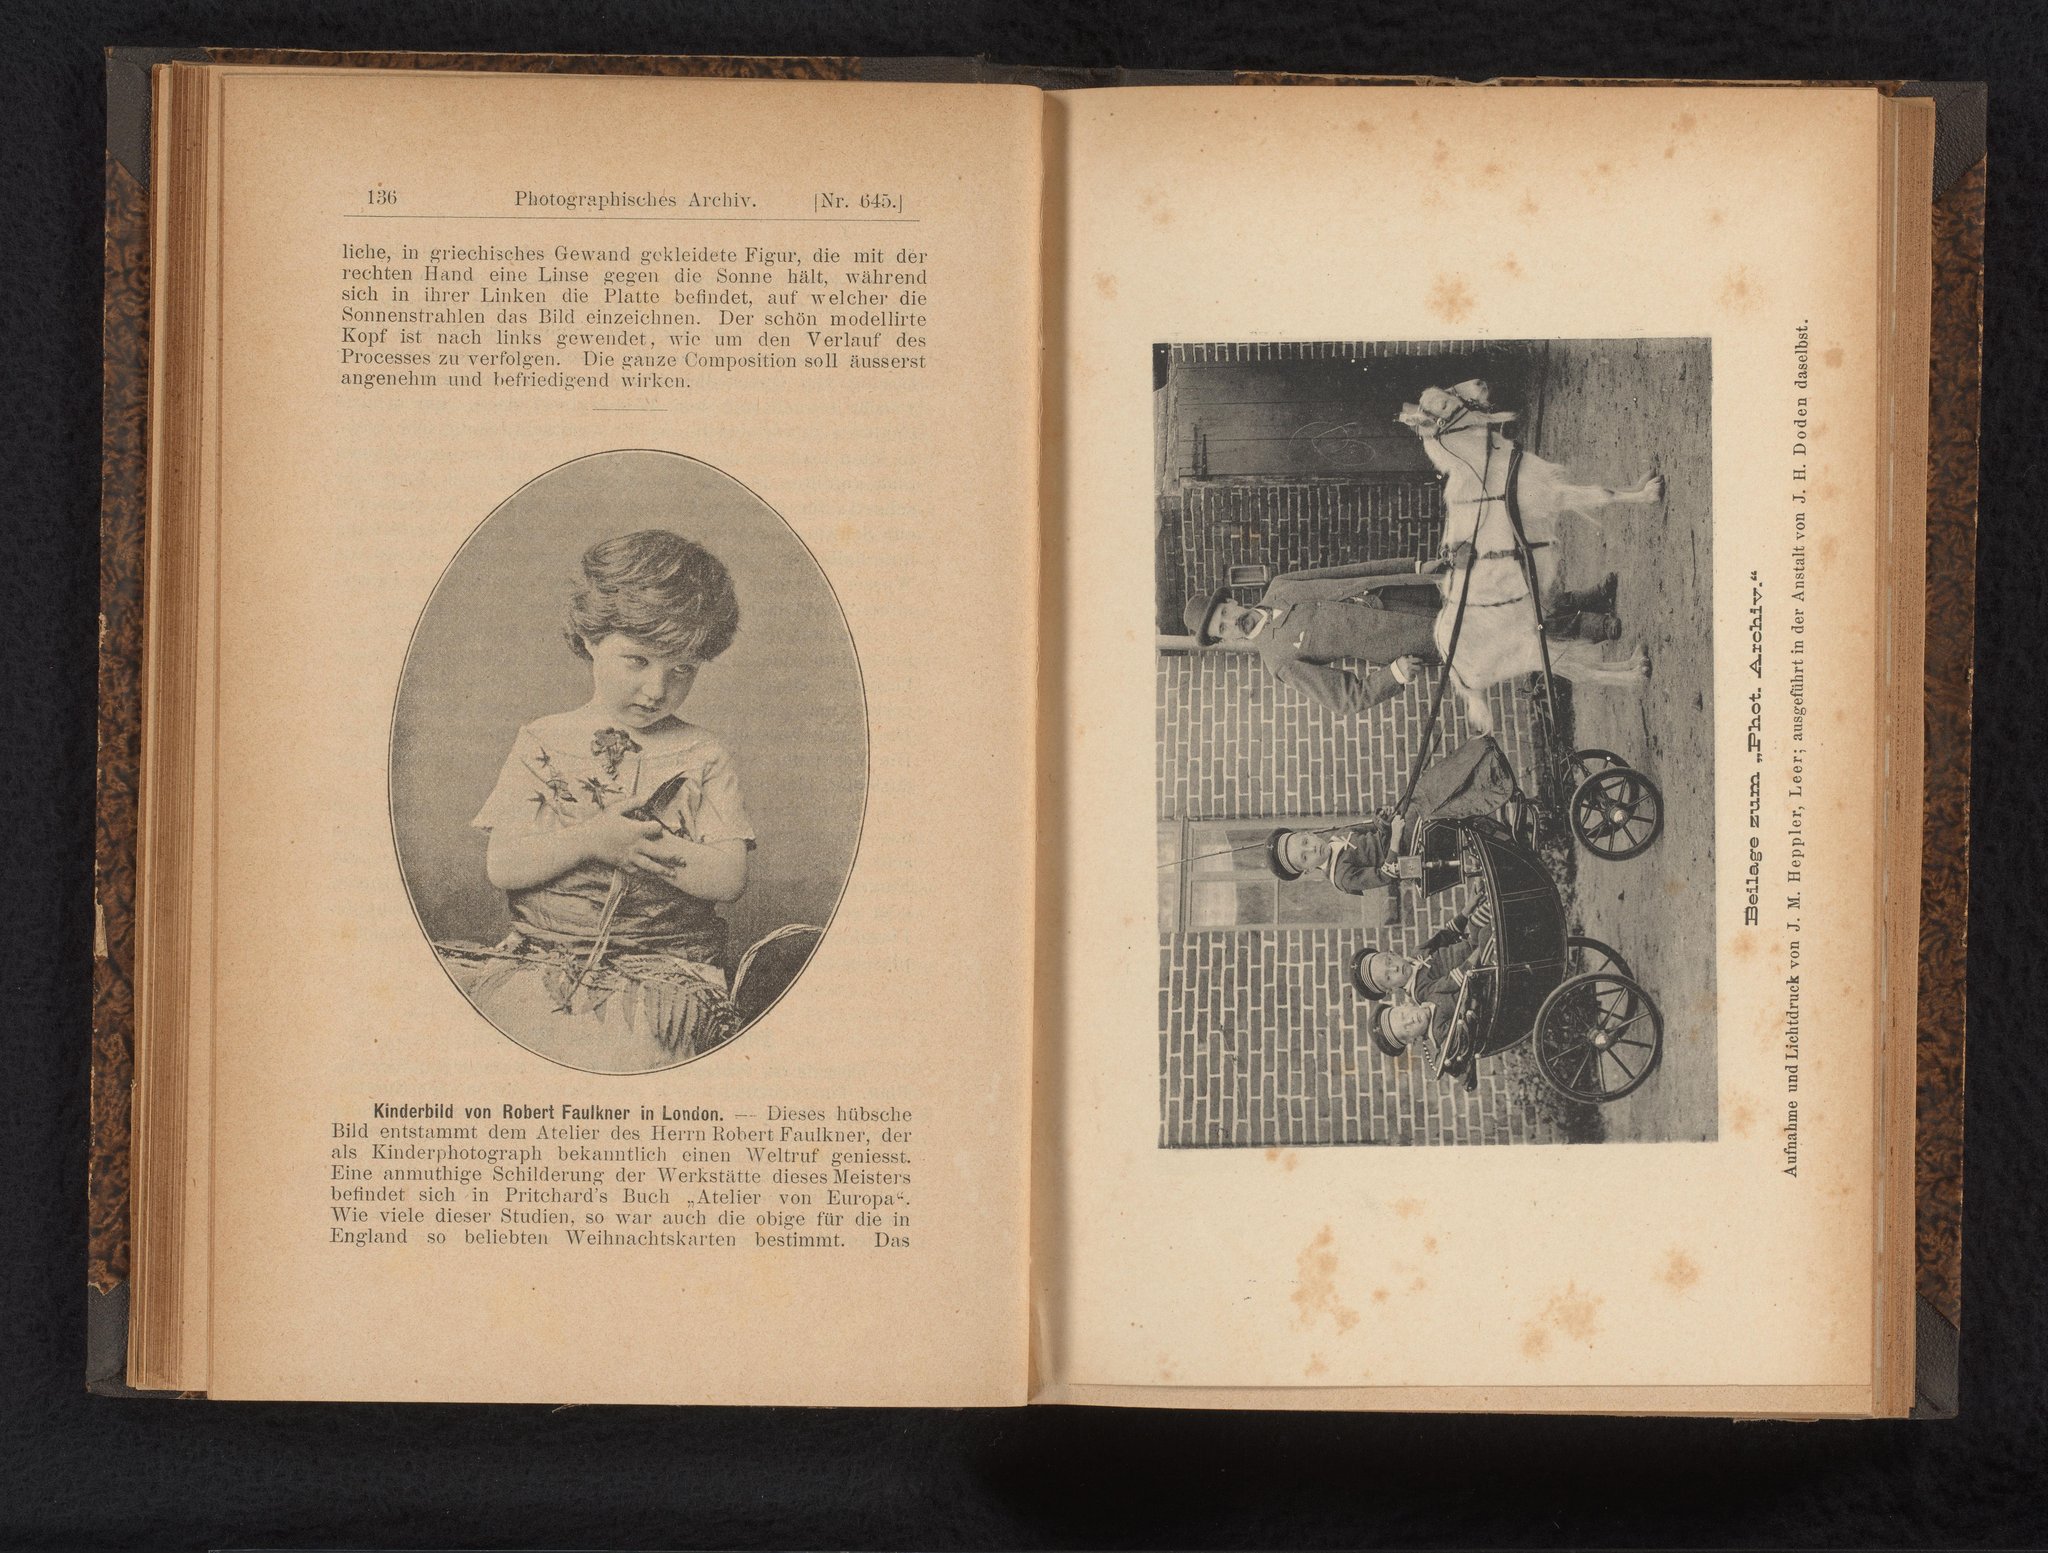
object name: page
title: Drie kinderen in een bokkenwagen met een staande man erbij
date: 1885-1890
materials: paper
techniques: photograph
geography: leer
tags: four-wheeled vehicle drawn by one animal, ensemble of pieces of clothing: sailor suit, goat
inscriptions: inscription: ‘Beilage zum "Phot. Archiv."’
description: Prent op ongenummerde pagina tegenover pagina 136.